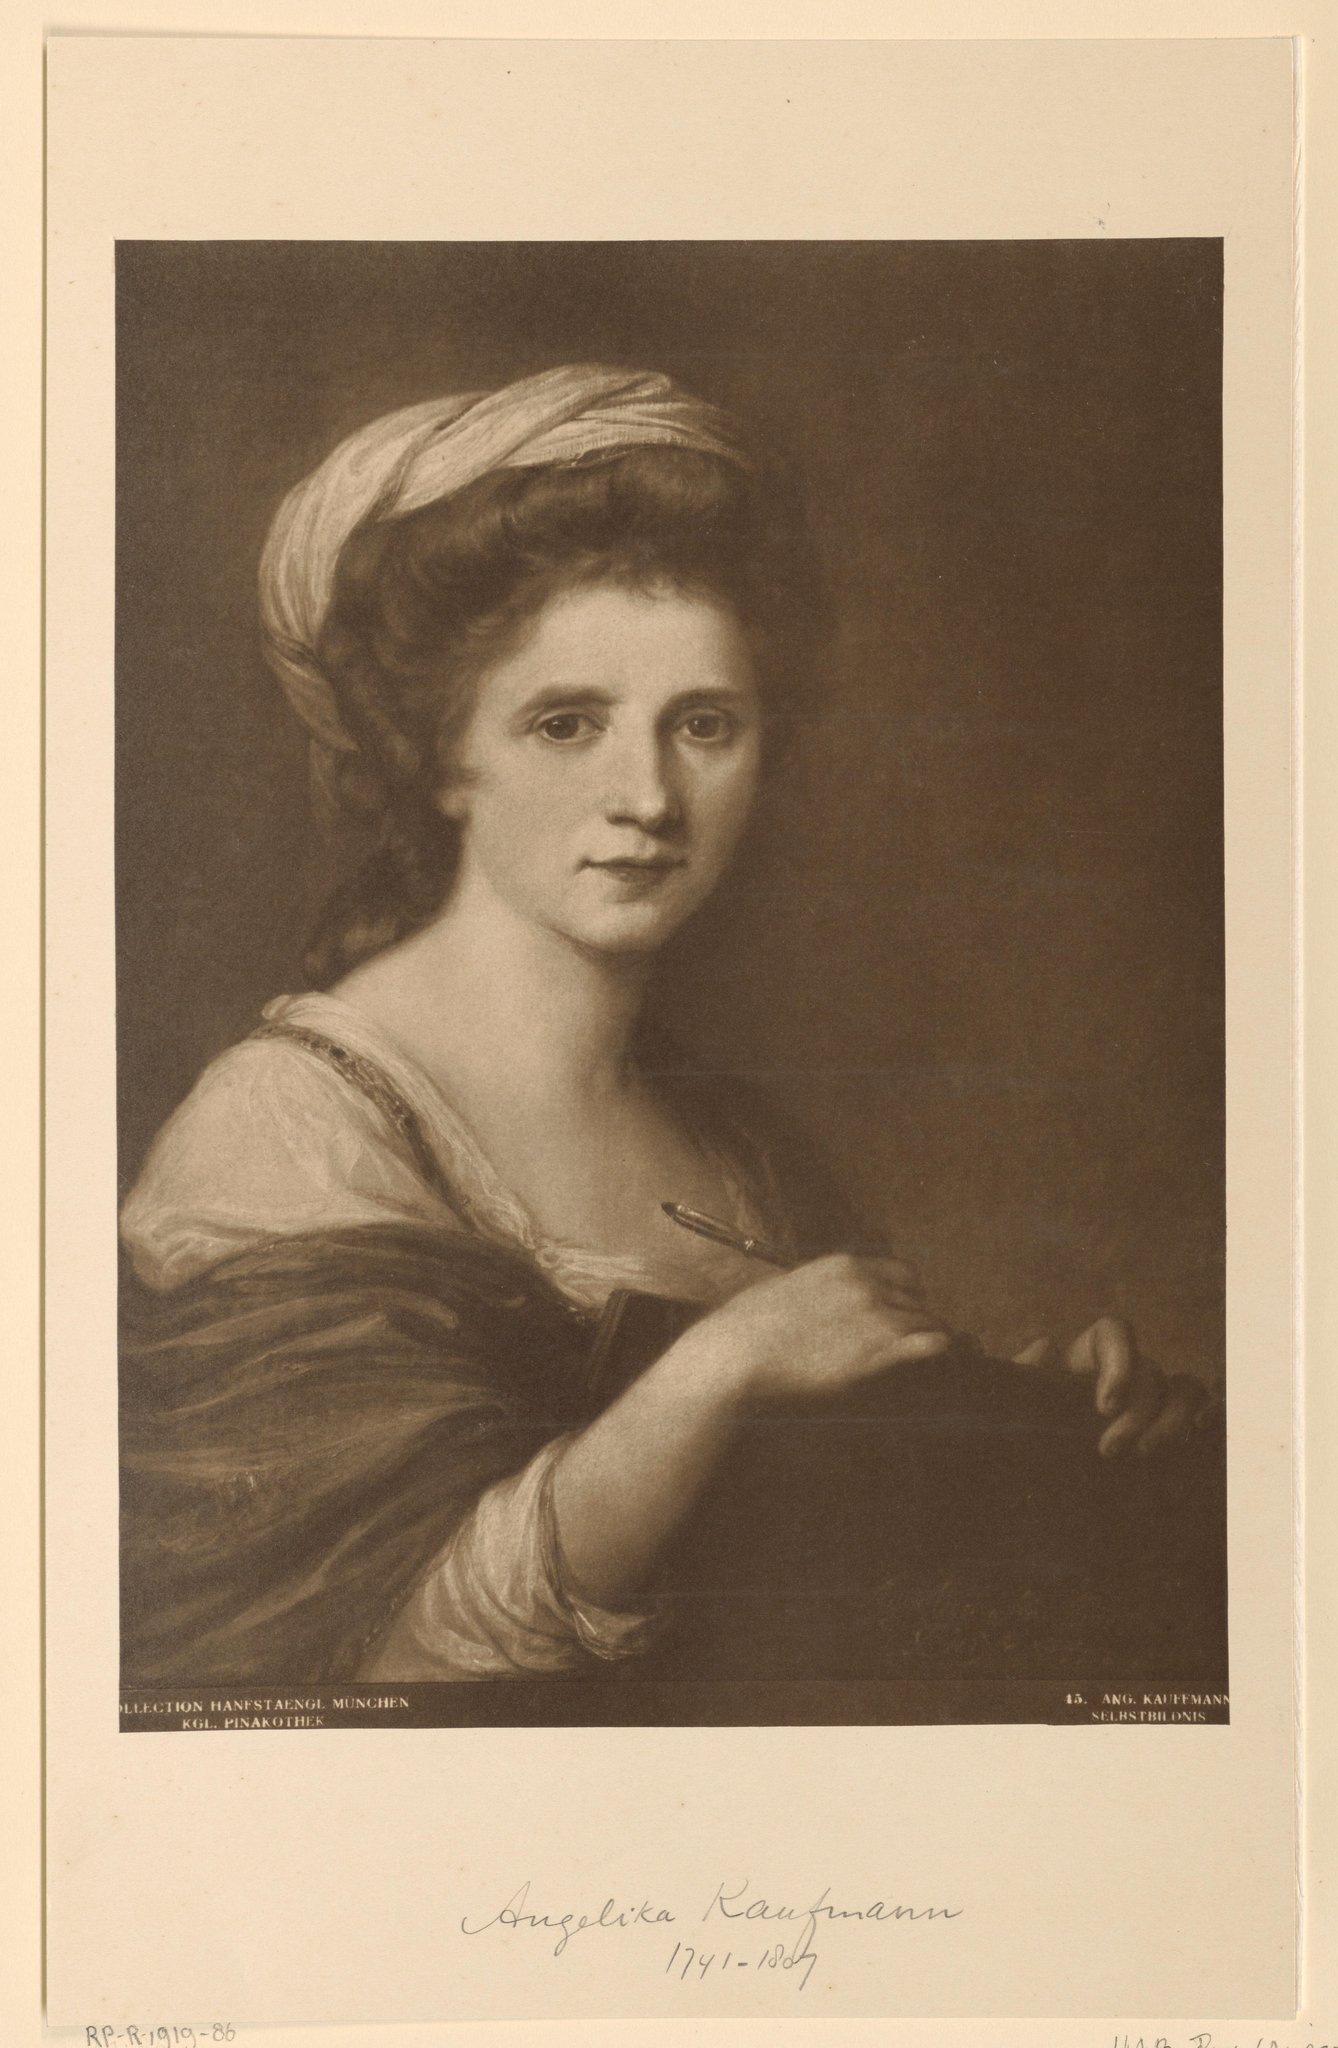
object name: reproduction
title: Zelfportret van Angelica Kauffmann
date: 1845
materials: paper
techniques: photography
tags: rome, draughtsman, angelica kauffmann, historical persons - bb - woman, portrait, self-portrait of painter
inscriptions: collector's mark: Lugt 2228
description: Foto mogelijk uit: Dillis, Johann Georg von. Catalogue des tableaux de la Pinacothèque royale à Munich. München: s.n., 1845.